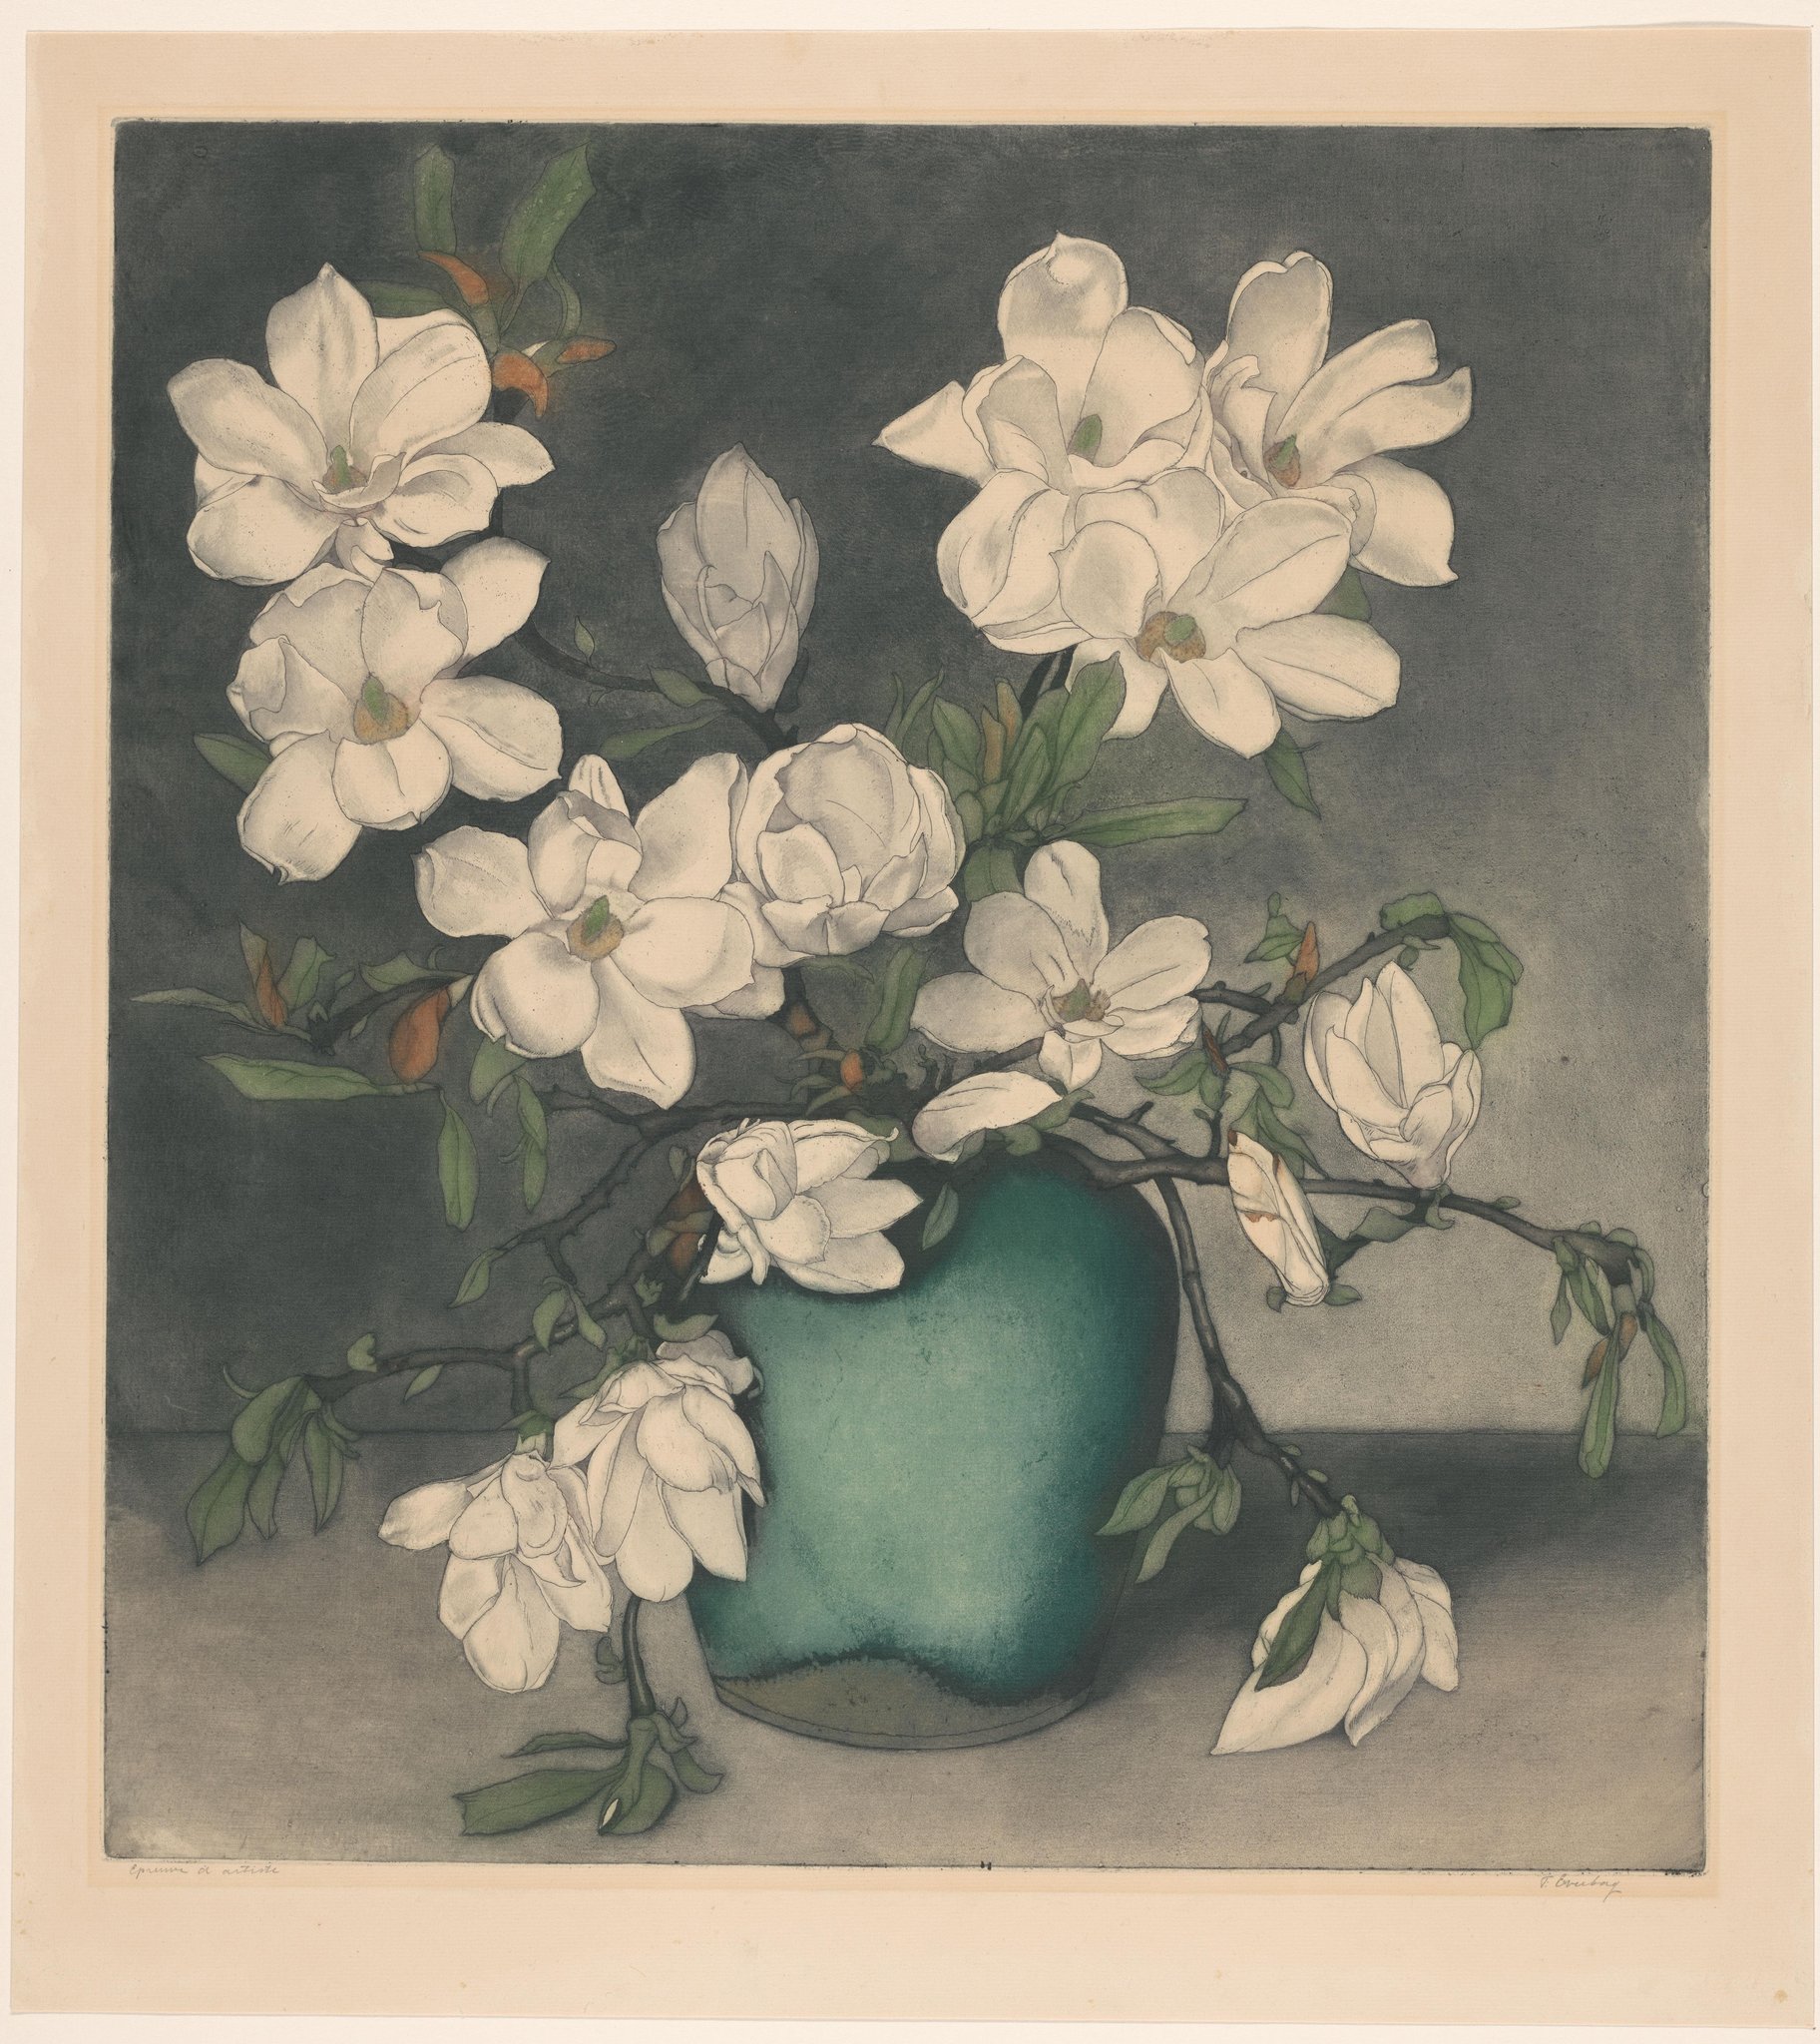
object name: print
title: Magnoliatakken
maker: frans everbag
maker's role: draughtsman, print maker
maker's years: 1877-1947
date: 1887-1947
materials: paper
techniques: aquatint, etching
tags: flowers in a vase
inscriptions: inscription: ‘Epreuve de artiste’, collector's mark: Lugt 2228